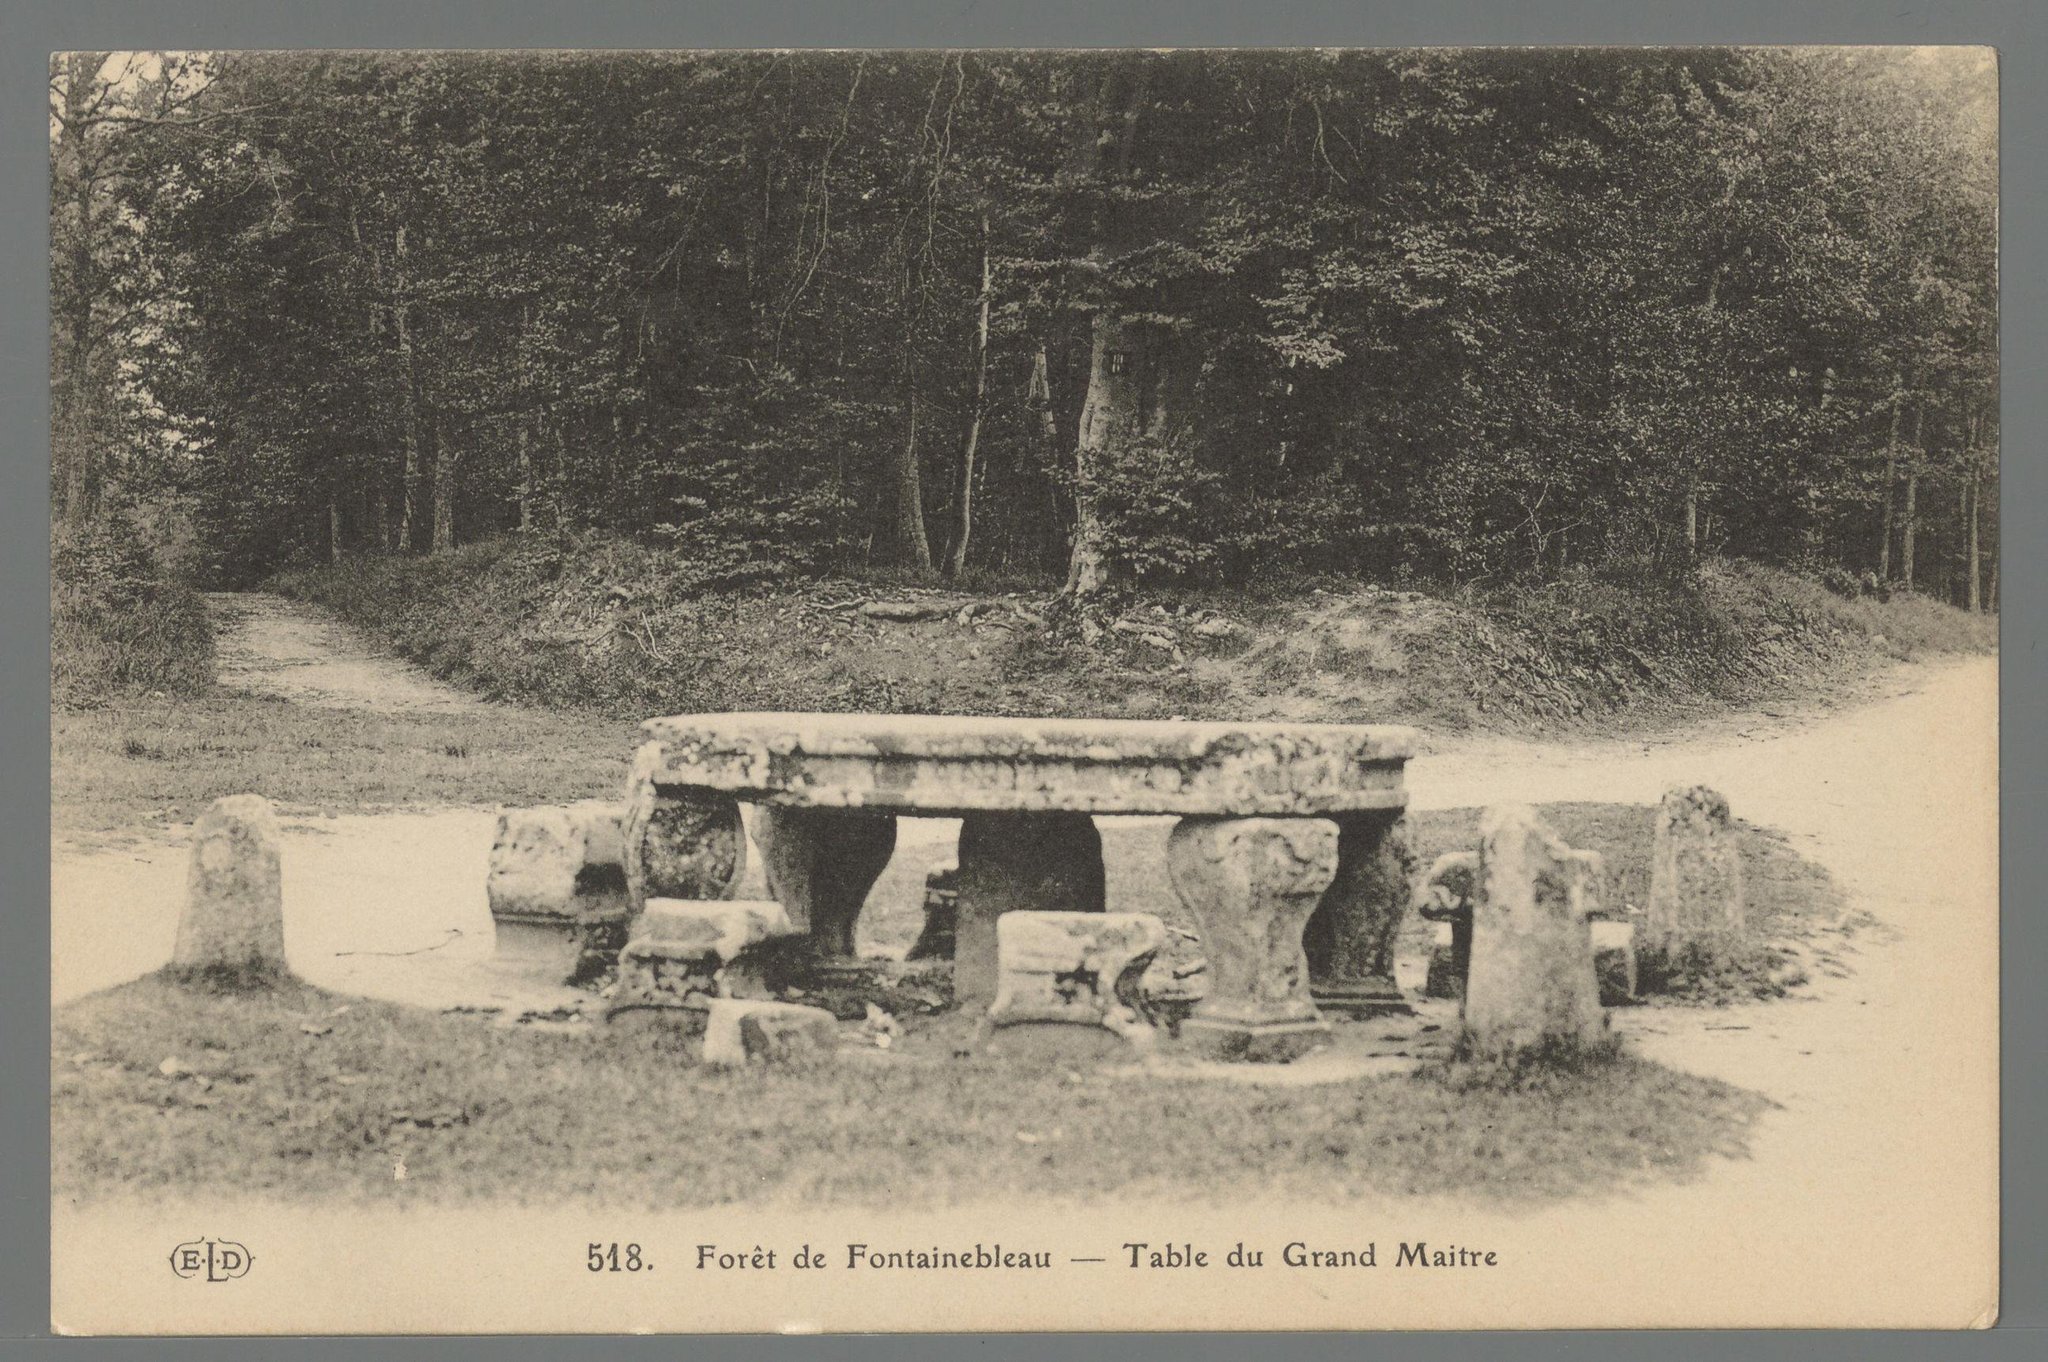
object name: photomechanical print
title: Fôret de Fontainebleau. Table du Grand Maitre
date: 1904-1906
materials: cardboard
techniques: photograph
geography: paris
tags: furniture to put things on (+ stone), forest, wood, sculpture